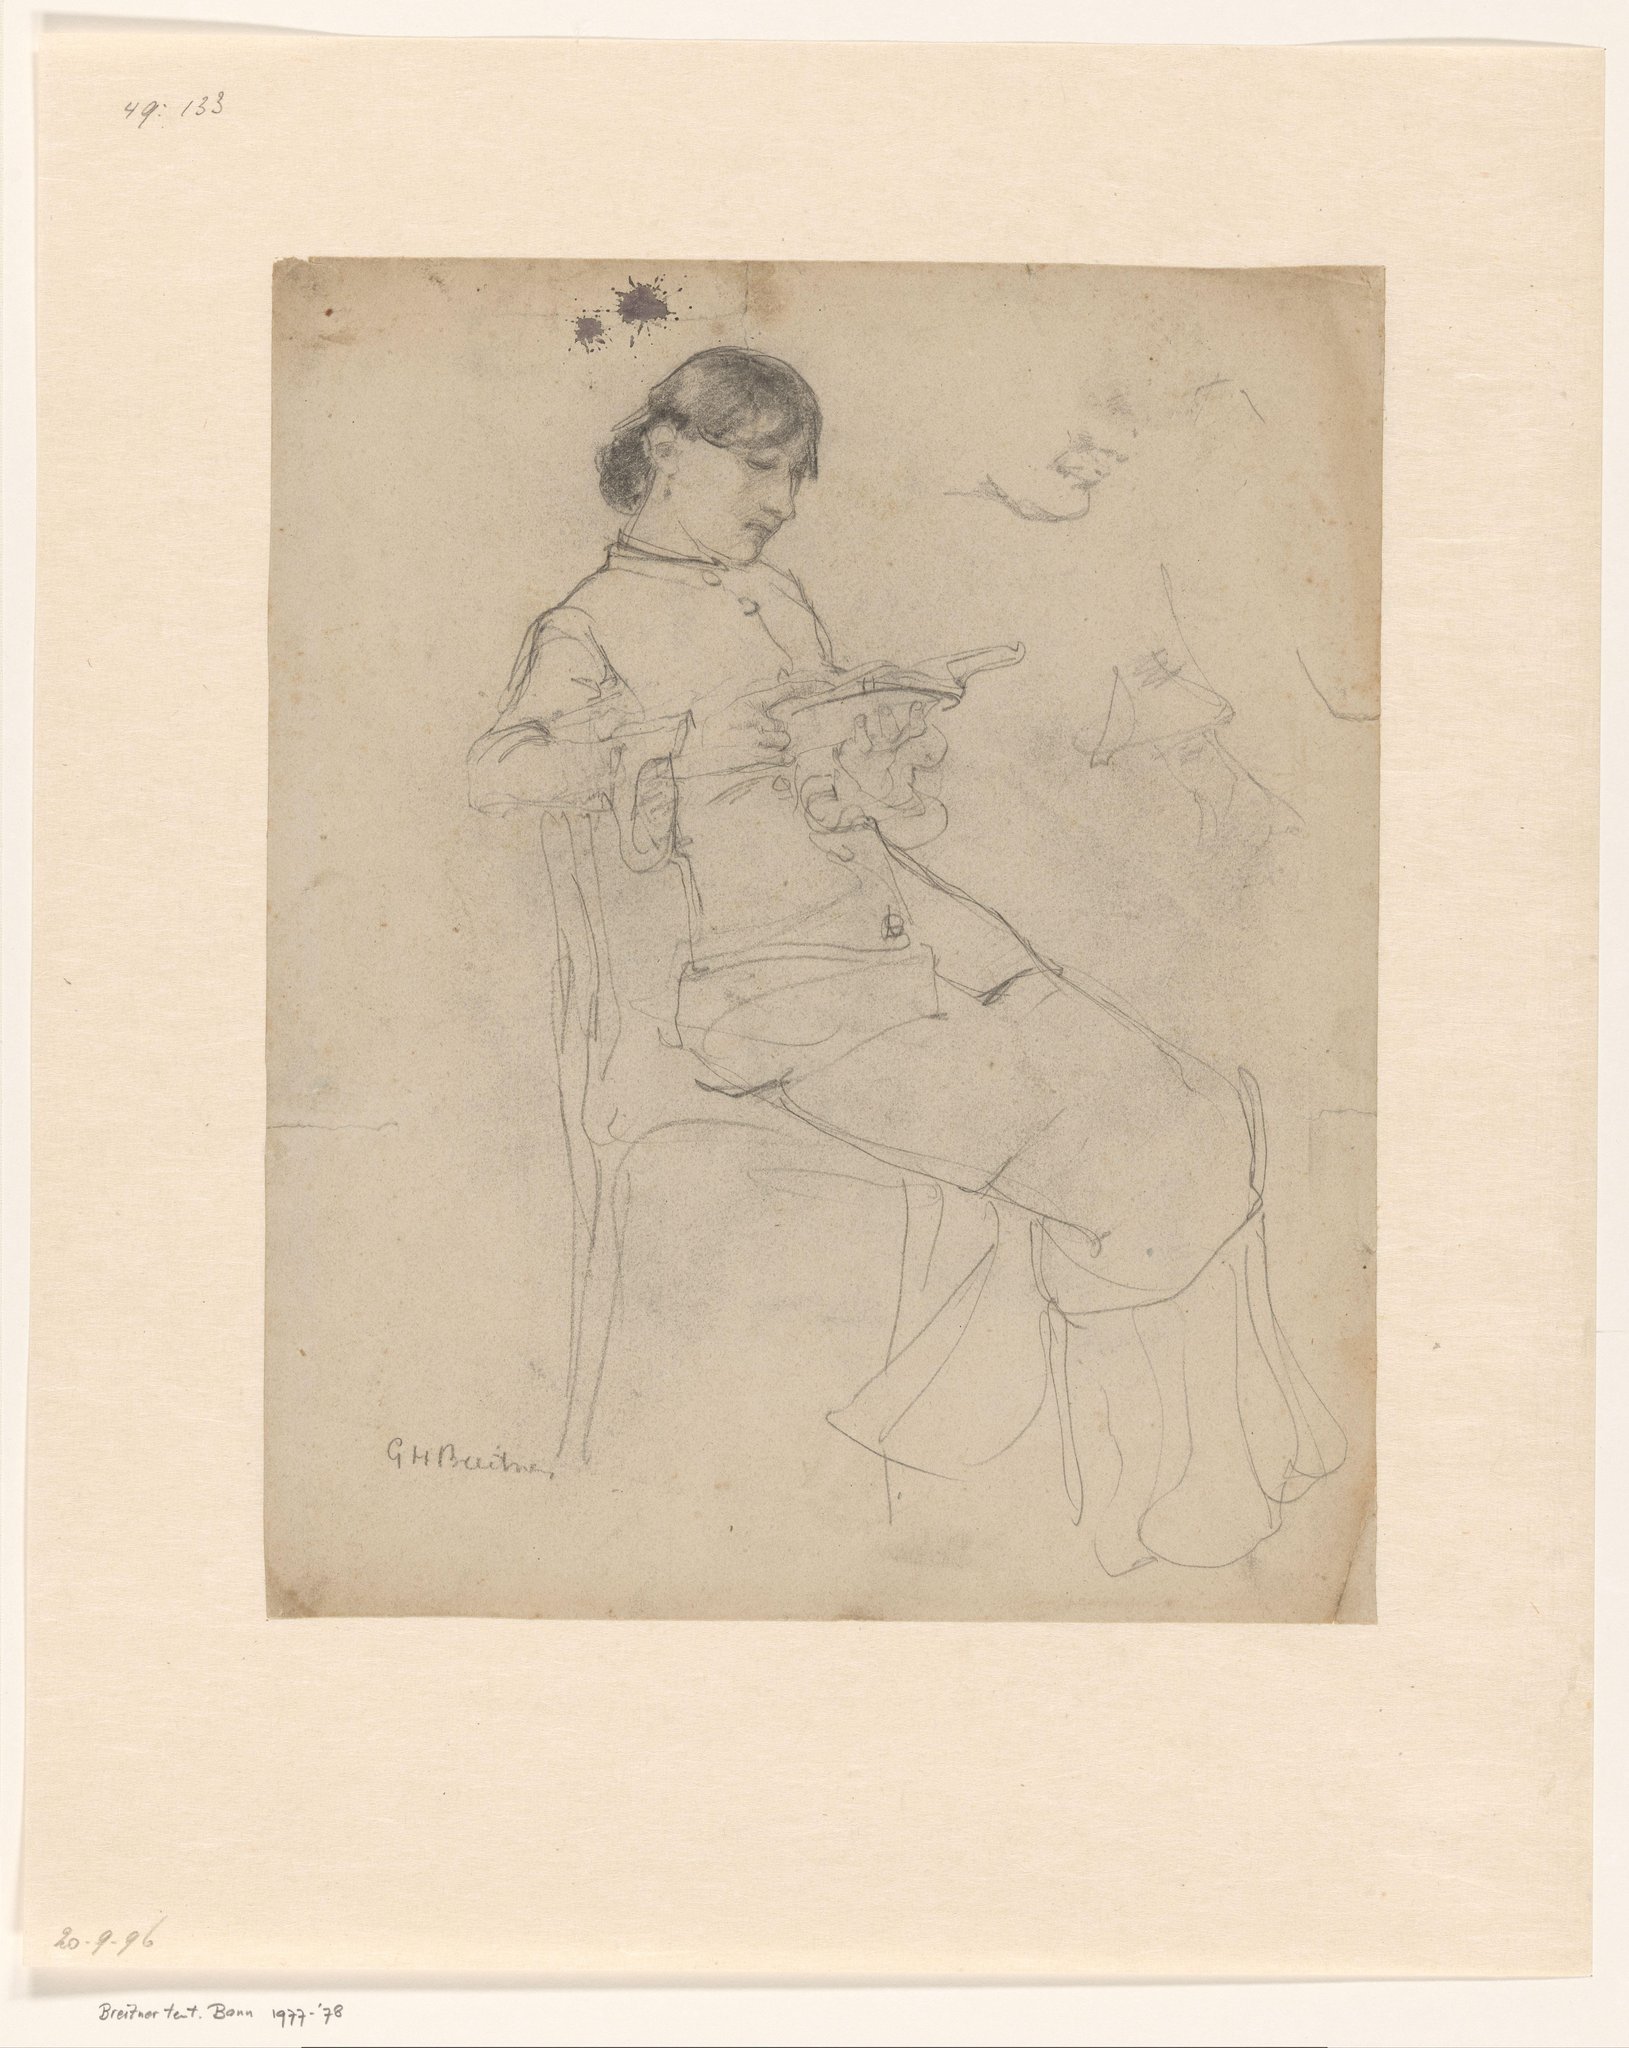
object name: drawing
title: Zittende lezende dame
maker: george hendrik breitner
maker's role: draughtsman, painter, print maker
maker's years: 1857-1923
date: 1867-1923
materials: chalk, paper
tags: reading